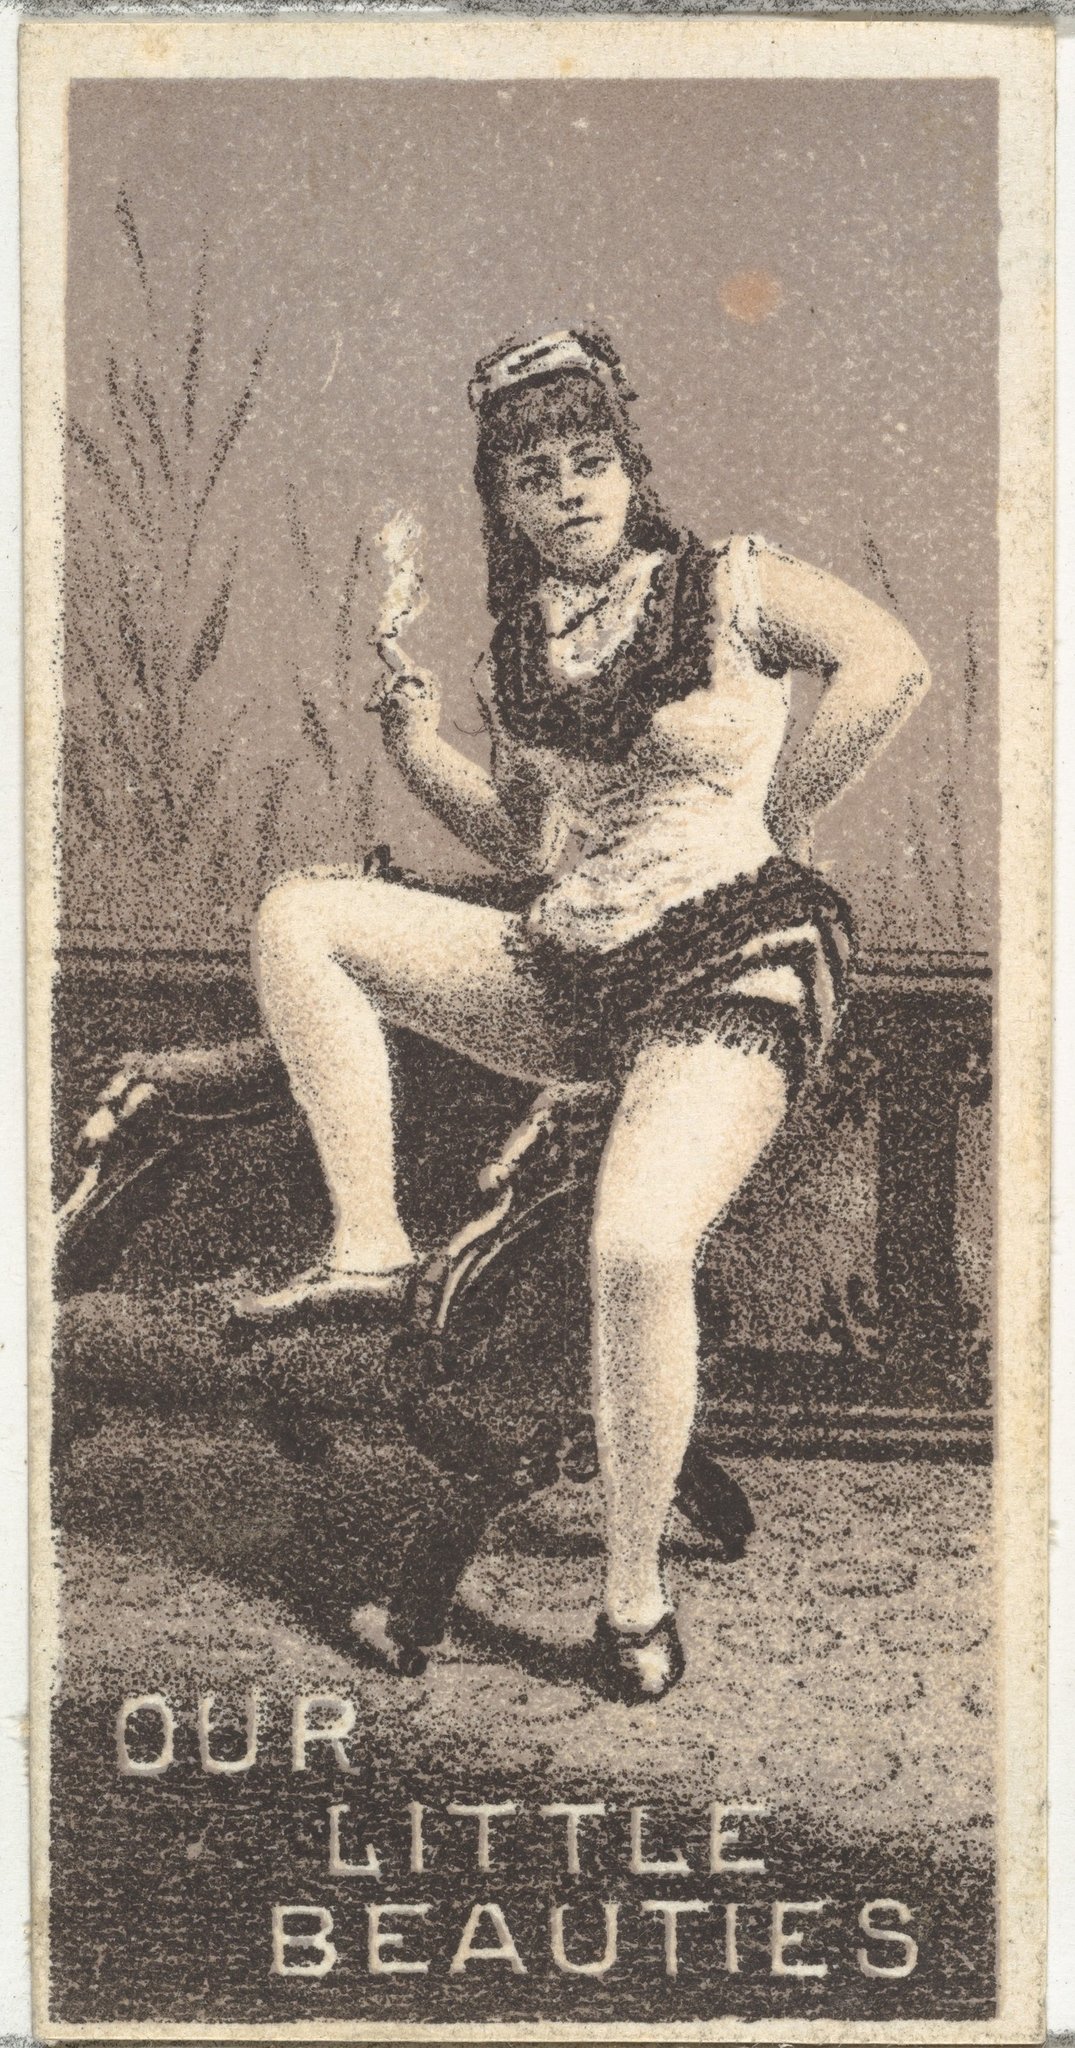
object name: print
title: From the Actresses series (N57) promoting Our Little Beauties Cigarettes for Allen & Ginter brand tobacco products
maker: allen & ginter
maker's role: publisher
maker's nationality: american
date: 1890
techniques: photolithograph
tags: portraits,women,smoking,actresses